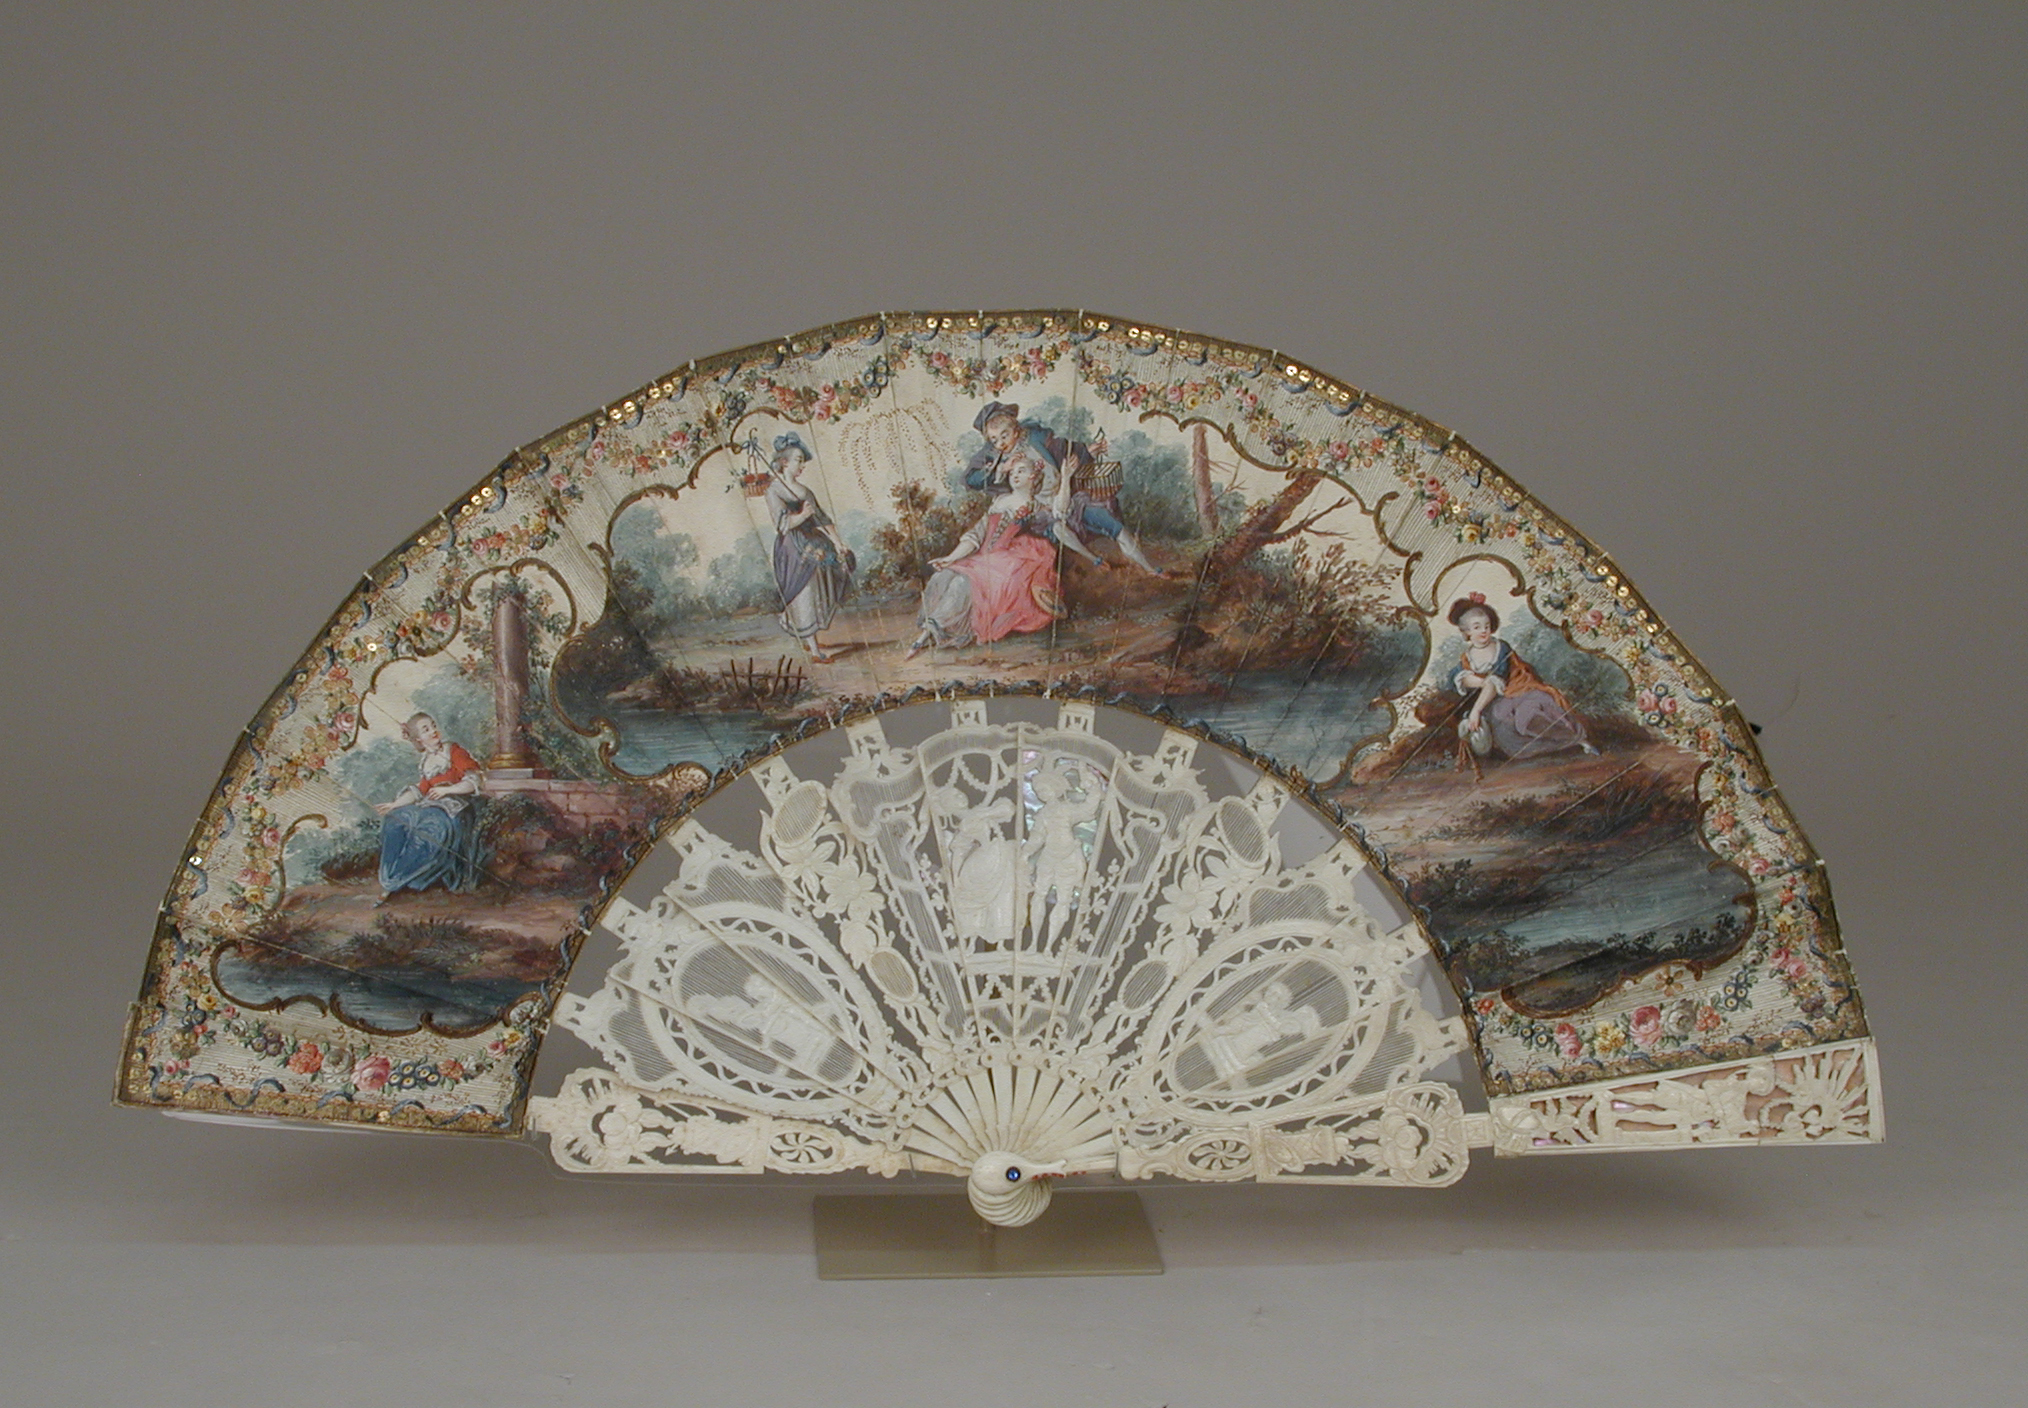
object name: fan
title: Folding fan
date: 1734-1766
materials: glass, ivory, mother of pearl, paper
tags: men,women